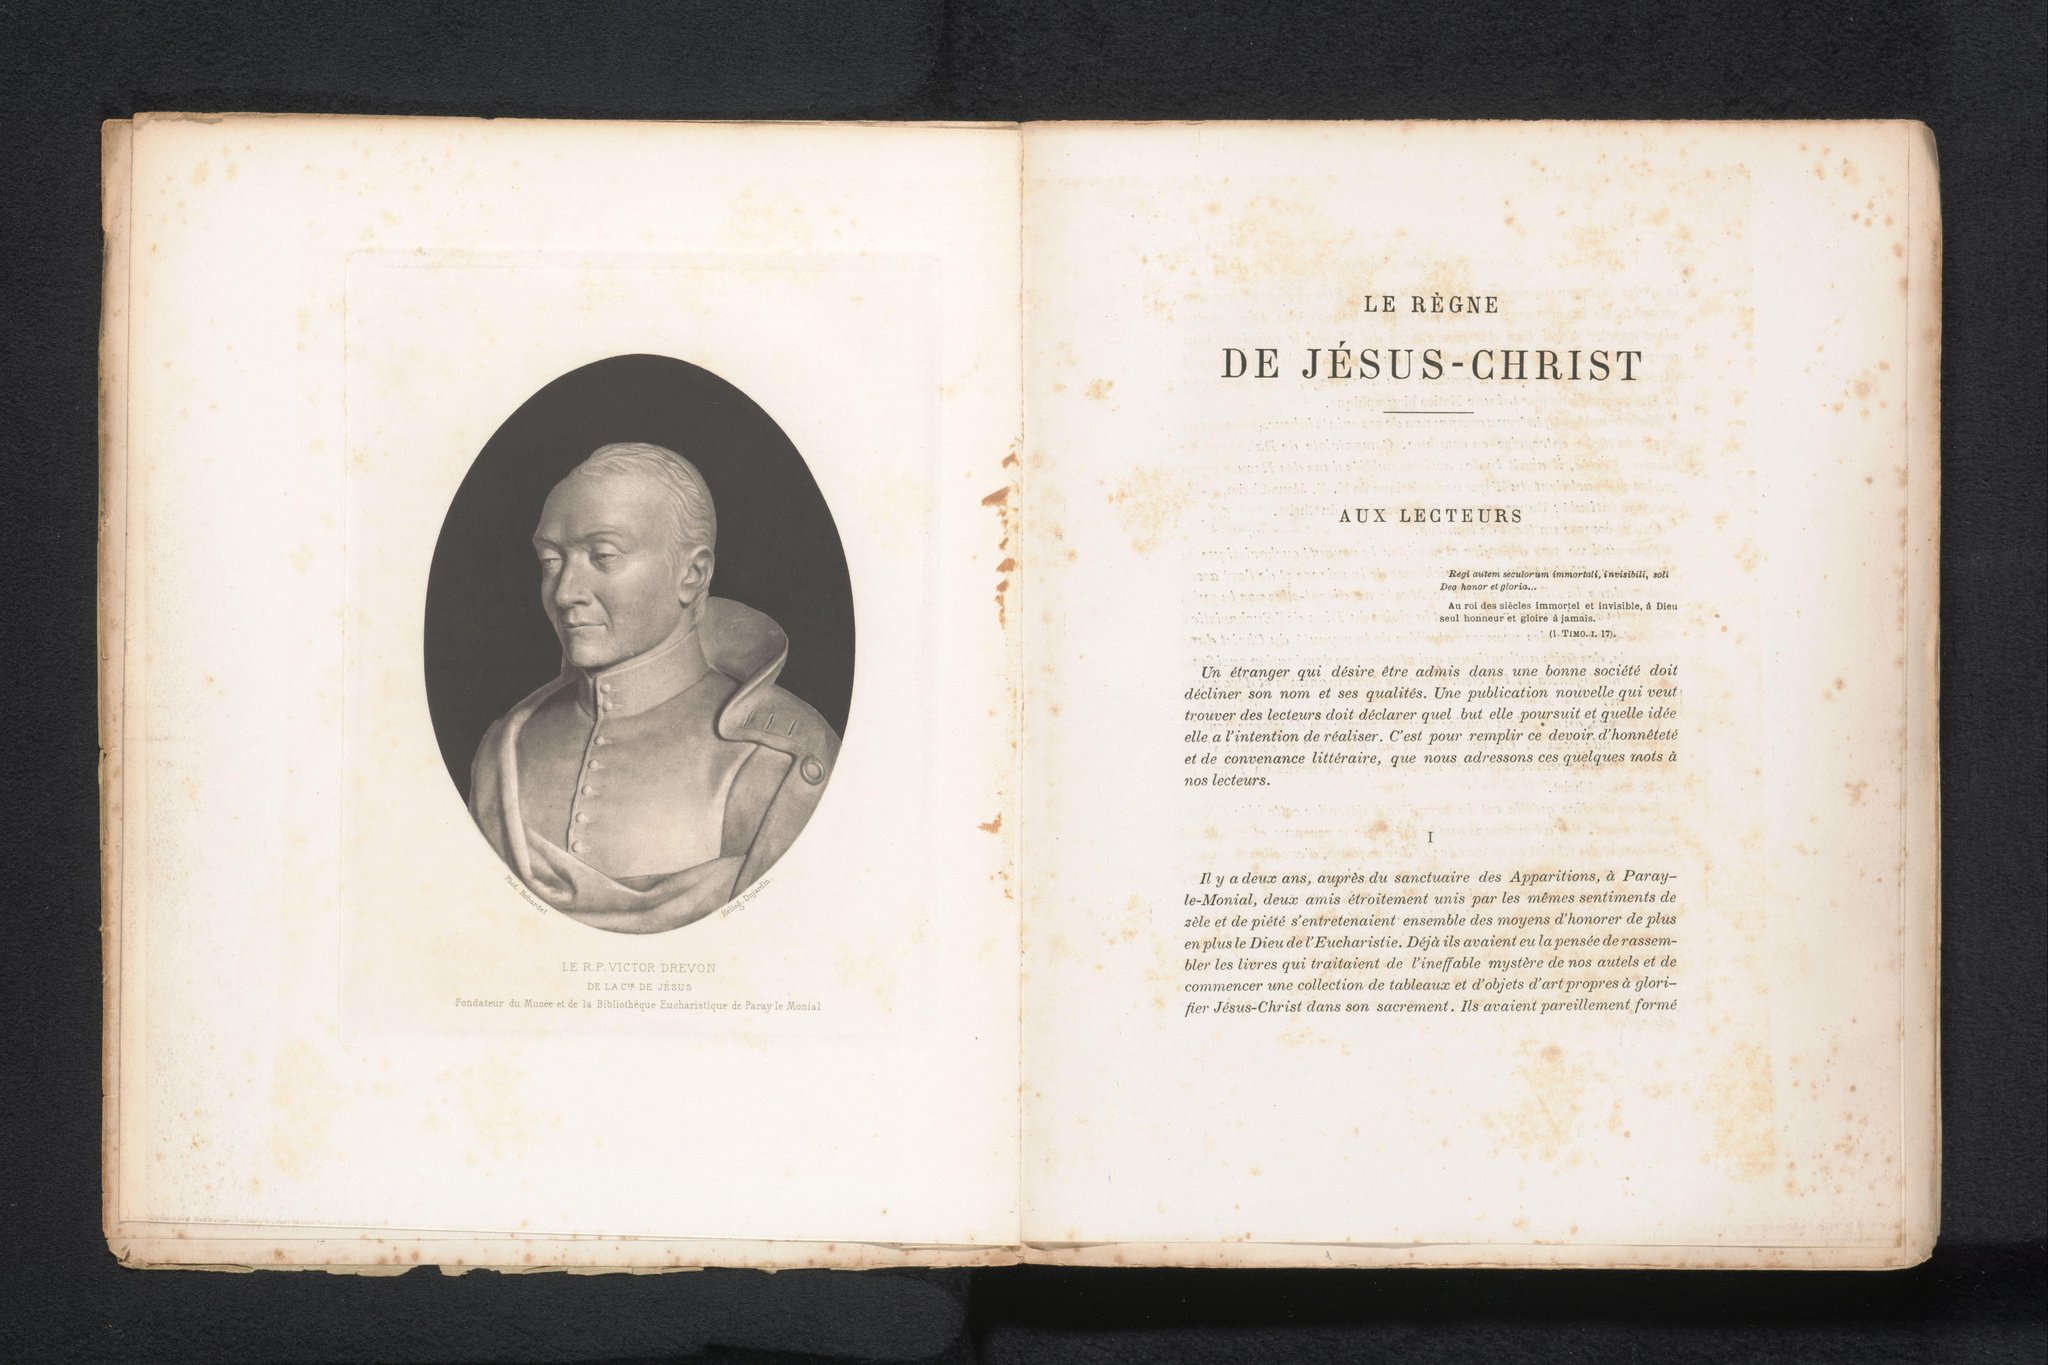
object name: page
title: Le R.P. Victor Drevon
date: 1878-1883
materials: paper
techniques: photoaquatint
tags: clergyman, theologian, historical persons, piece of sculpture, reproduction of a piece of sculpture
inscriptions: inscription: ‘DE LA Cie DE JÉSUS/ Fondateur du Musée et de la Bibliothèque Eucharistique de Paray le Monial’